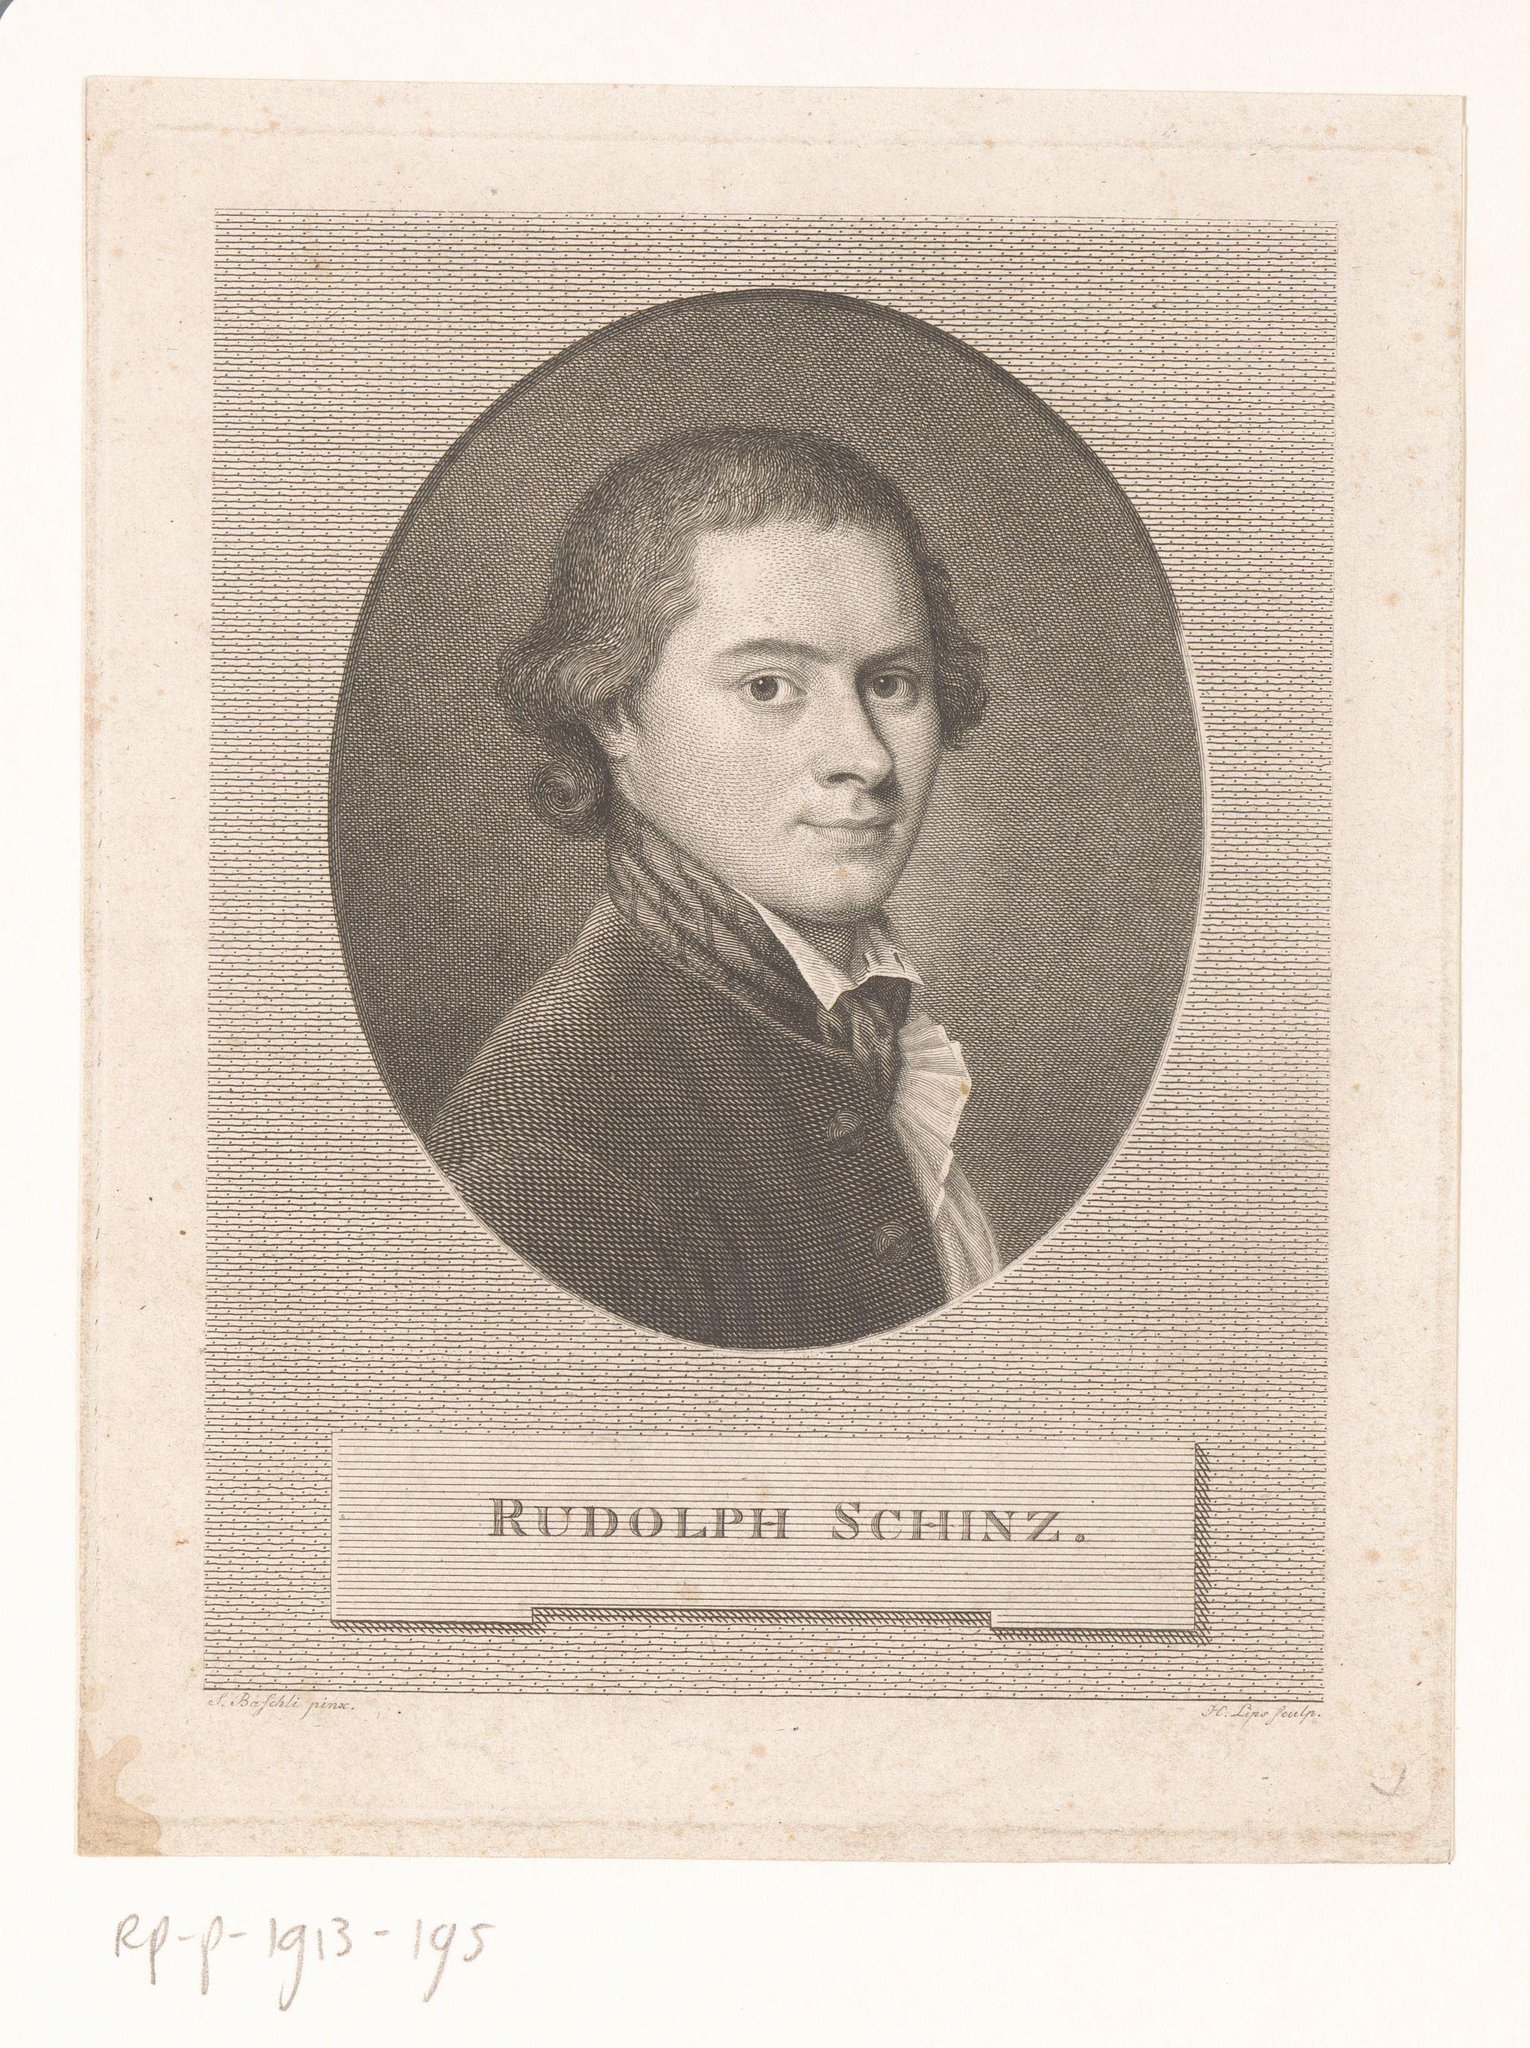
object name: print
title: Portret van Hans Rudolf Schinz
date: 1768-1817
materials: paper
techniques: engraving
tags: historical persons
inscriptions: collector's mark: Lugt 2228